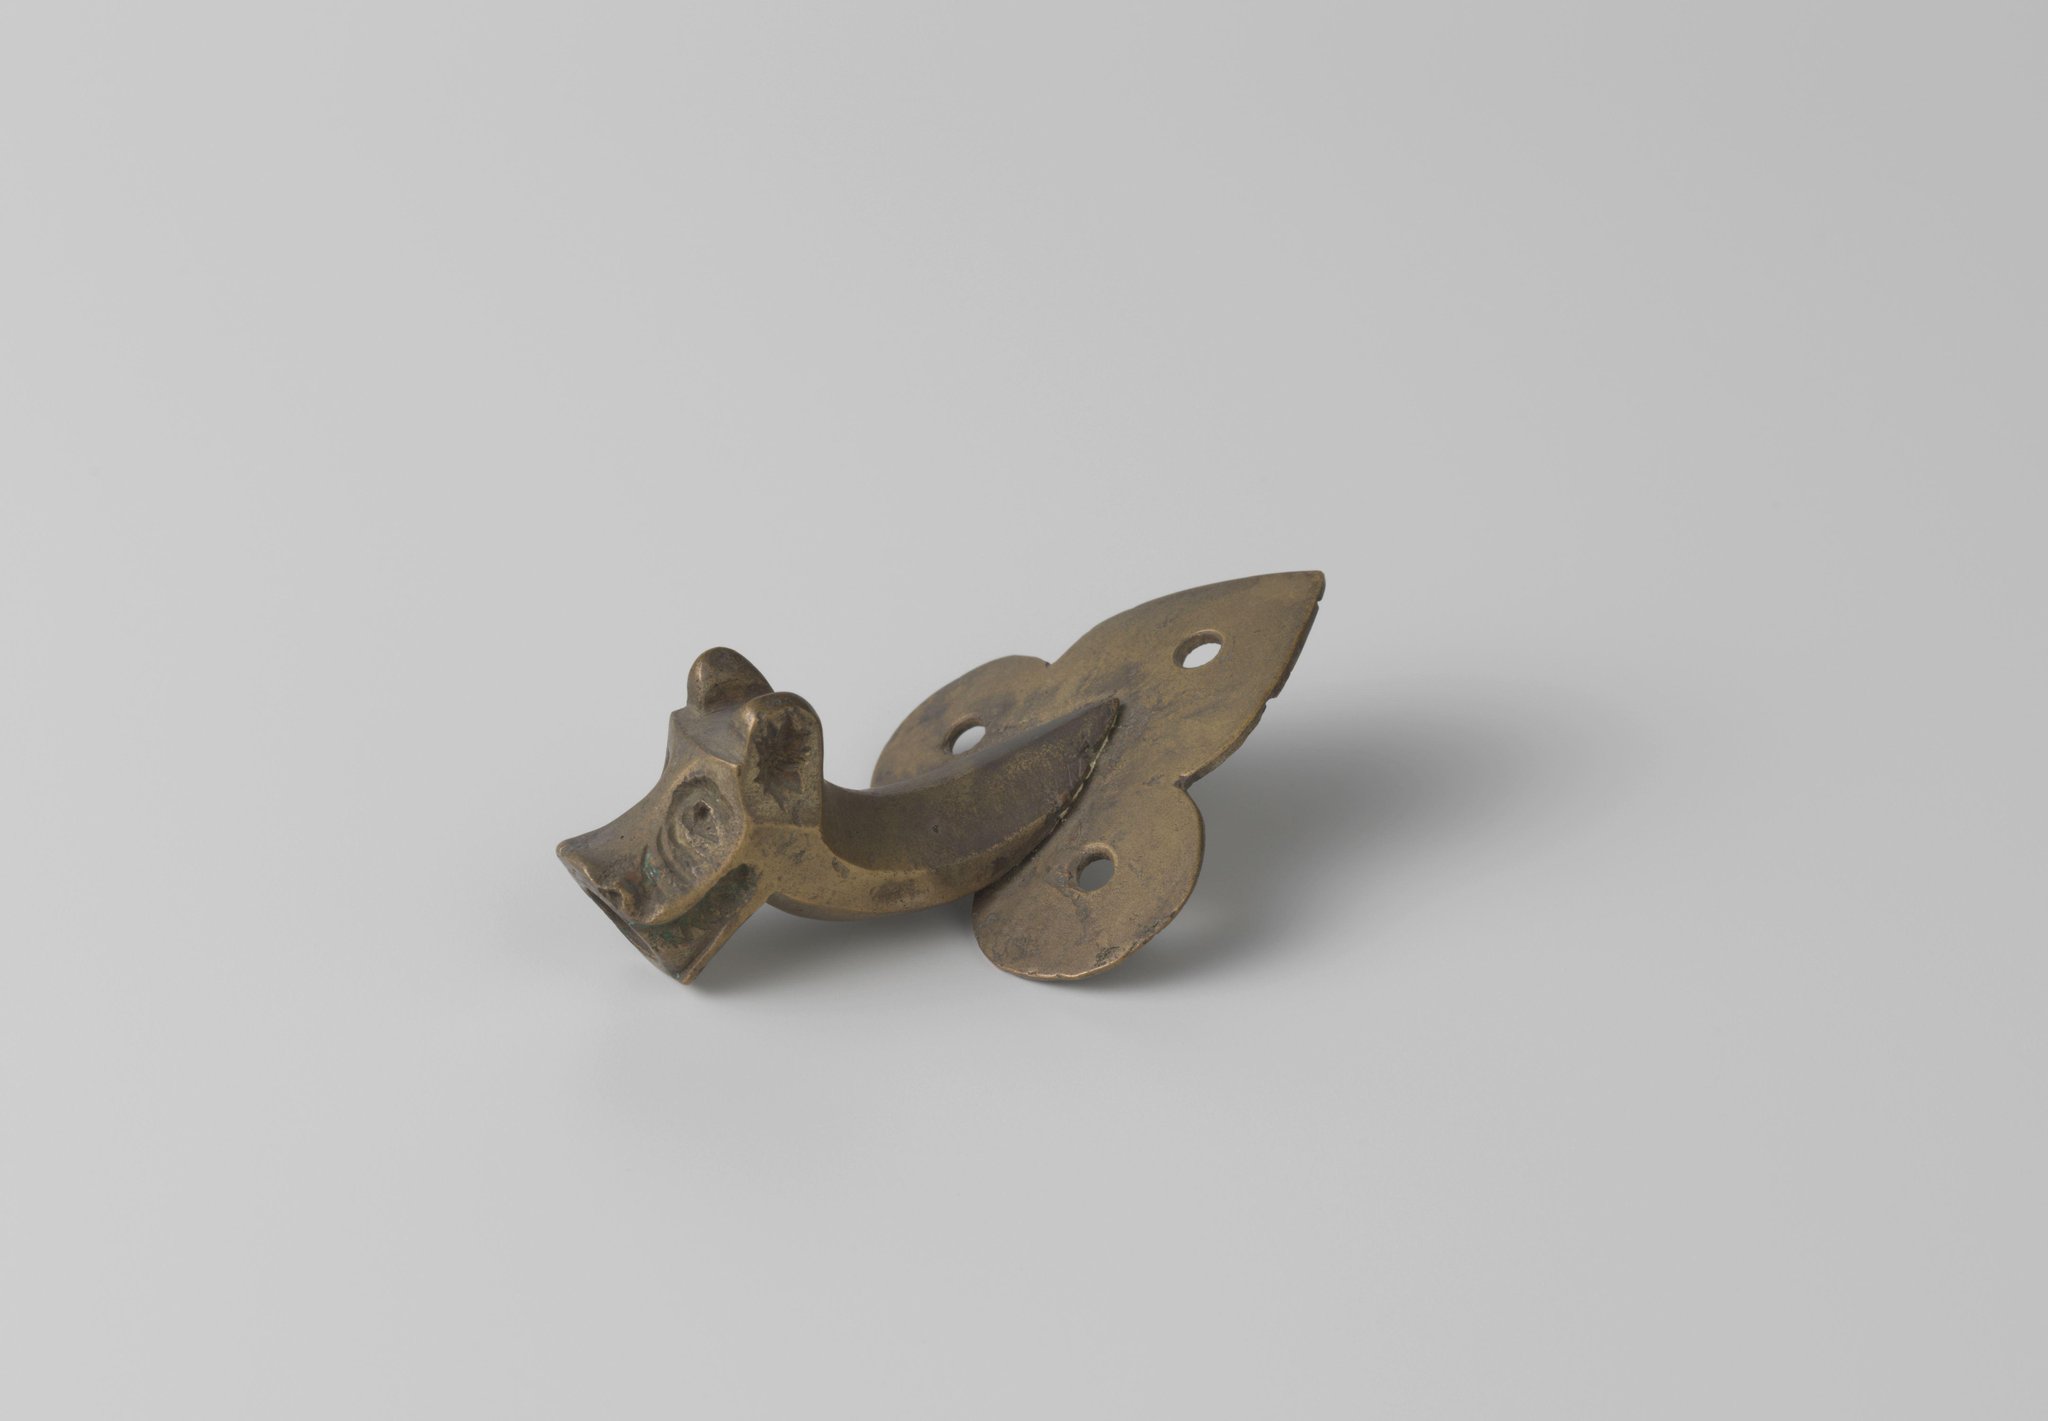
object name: part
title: Onderdeel, bestaande uit een driepas met daarop een dierenkop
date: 1400-1500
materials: brass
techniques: casting, soldering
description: Het voorwerp bestaat uit een uit plaat gemaakte driepas met drie gaten, waarop een uitsteeksel is gesoldeerd, dat eindigt in een dierenkop waarin een rond gat.